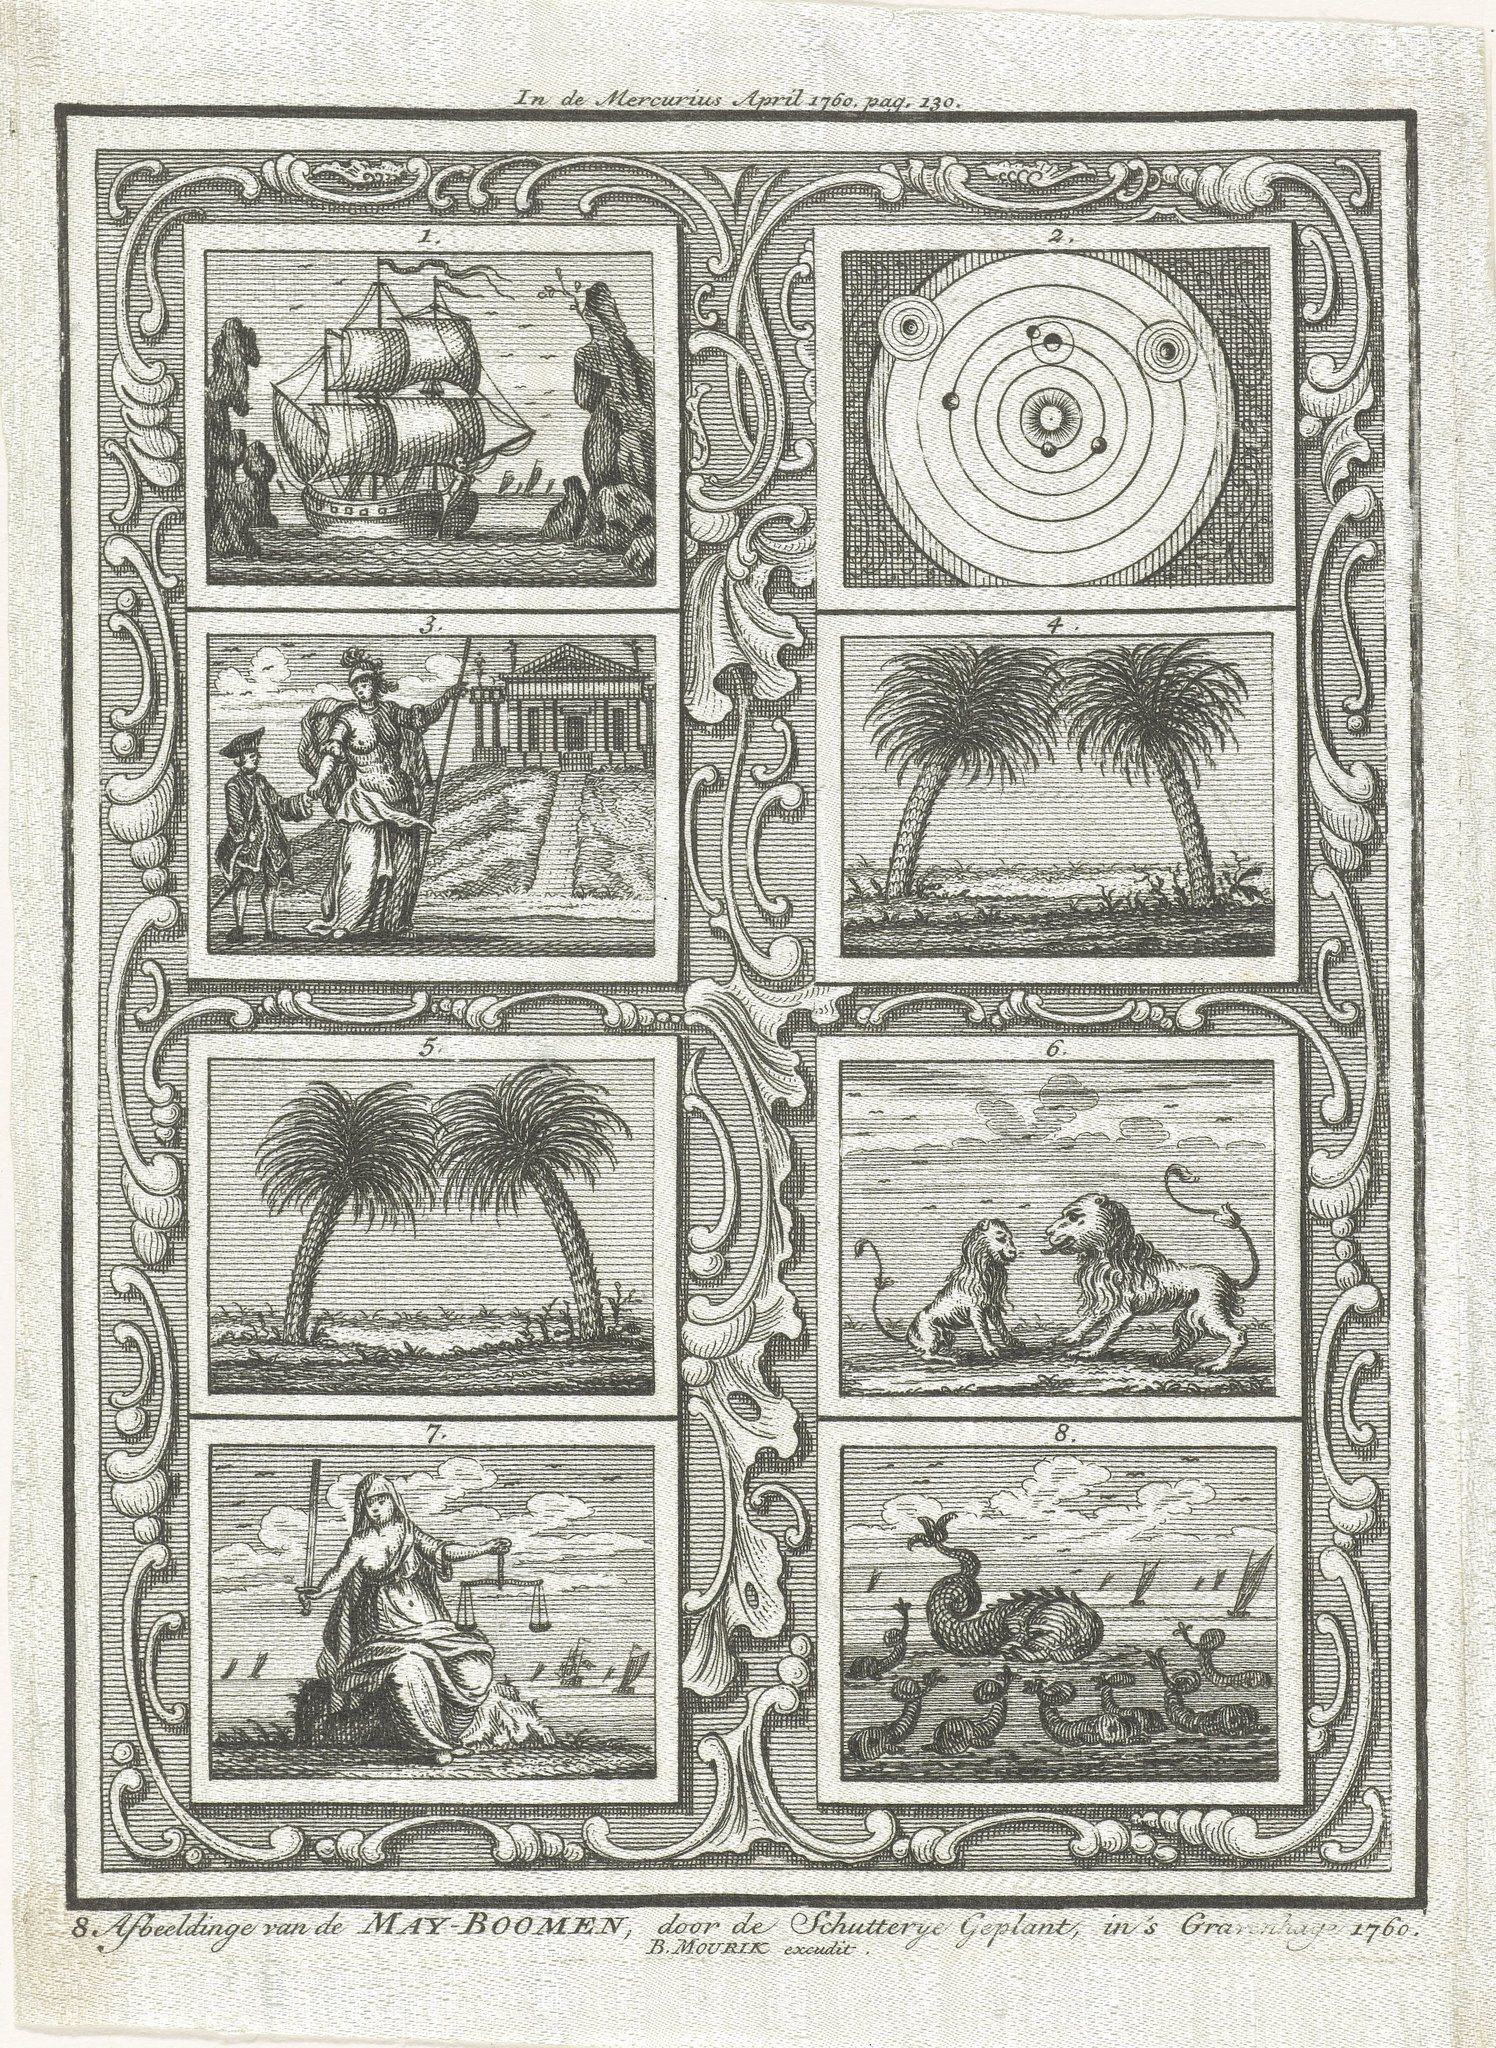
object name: print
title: 8 Afbeeldinge van de May-Boomen, door de Schutterye Geplant, in 's Gravenhage 1760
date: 1760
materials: textile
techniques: engraving, etching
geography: northern netherlands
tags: maypole, the hague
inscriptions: collector's mark: Lugt 2228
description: De acht allegorische voorstellingen of emblemen van de meiboom geplant door de Schutterij van Den Haag in het jaar 1760.